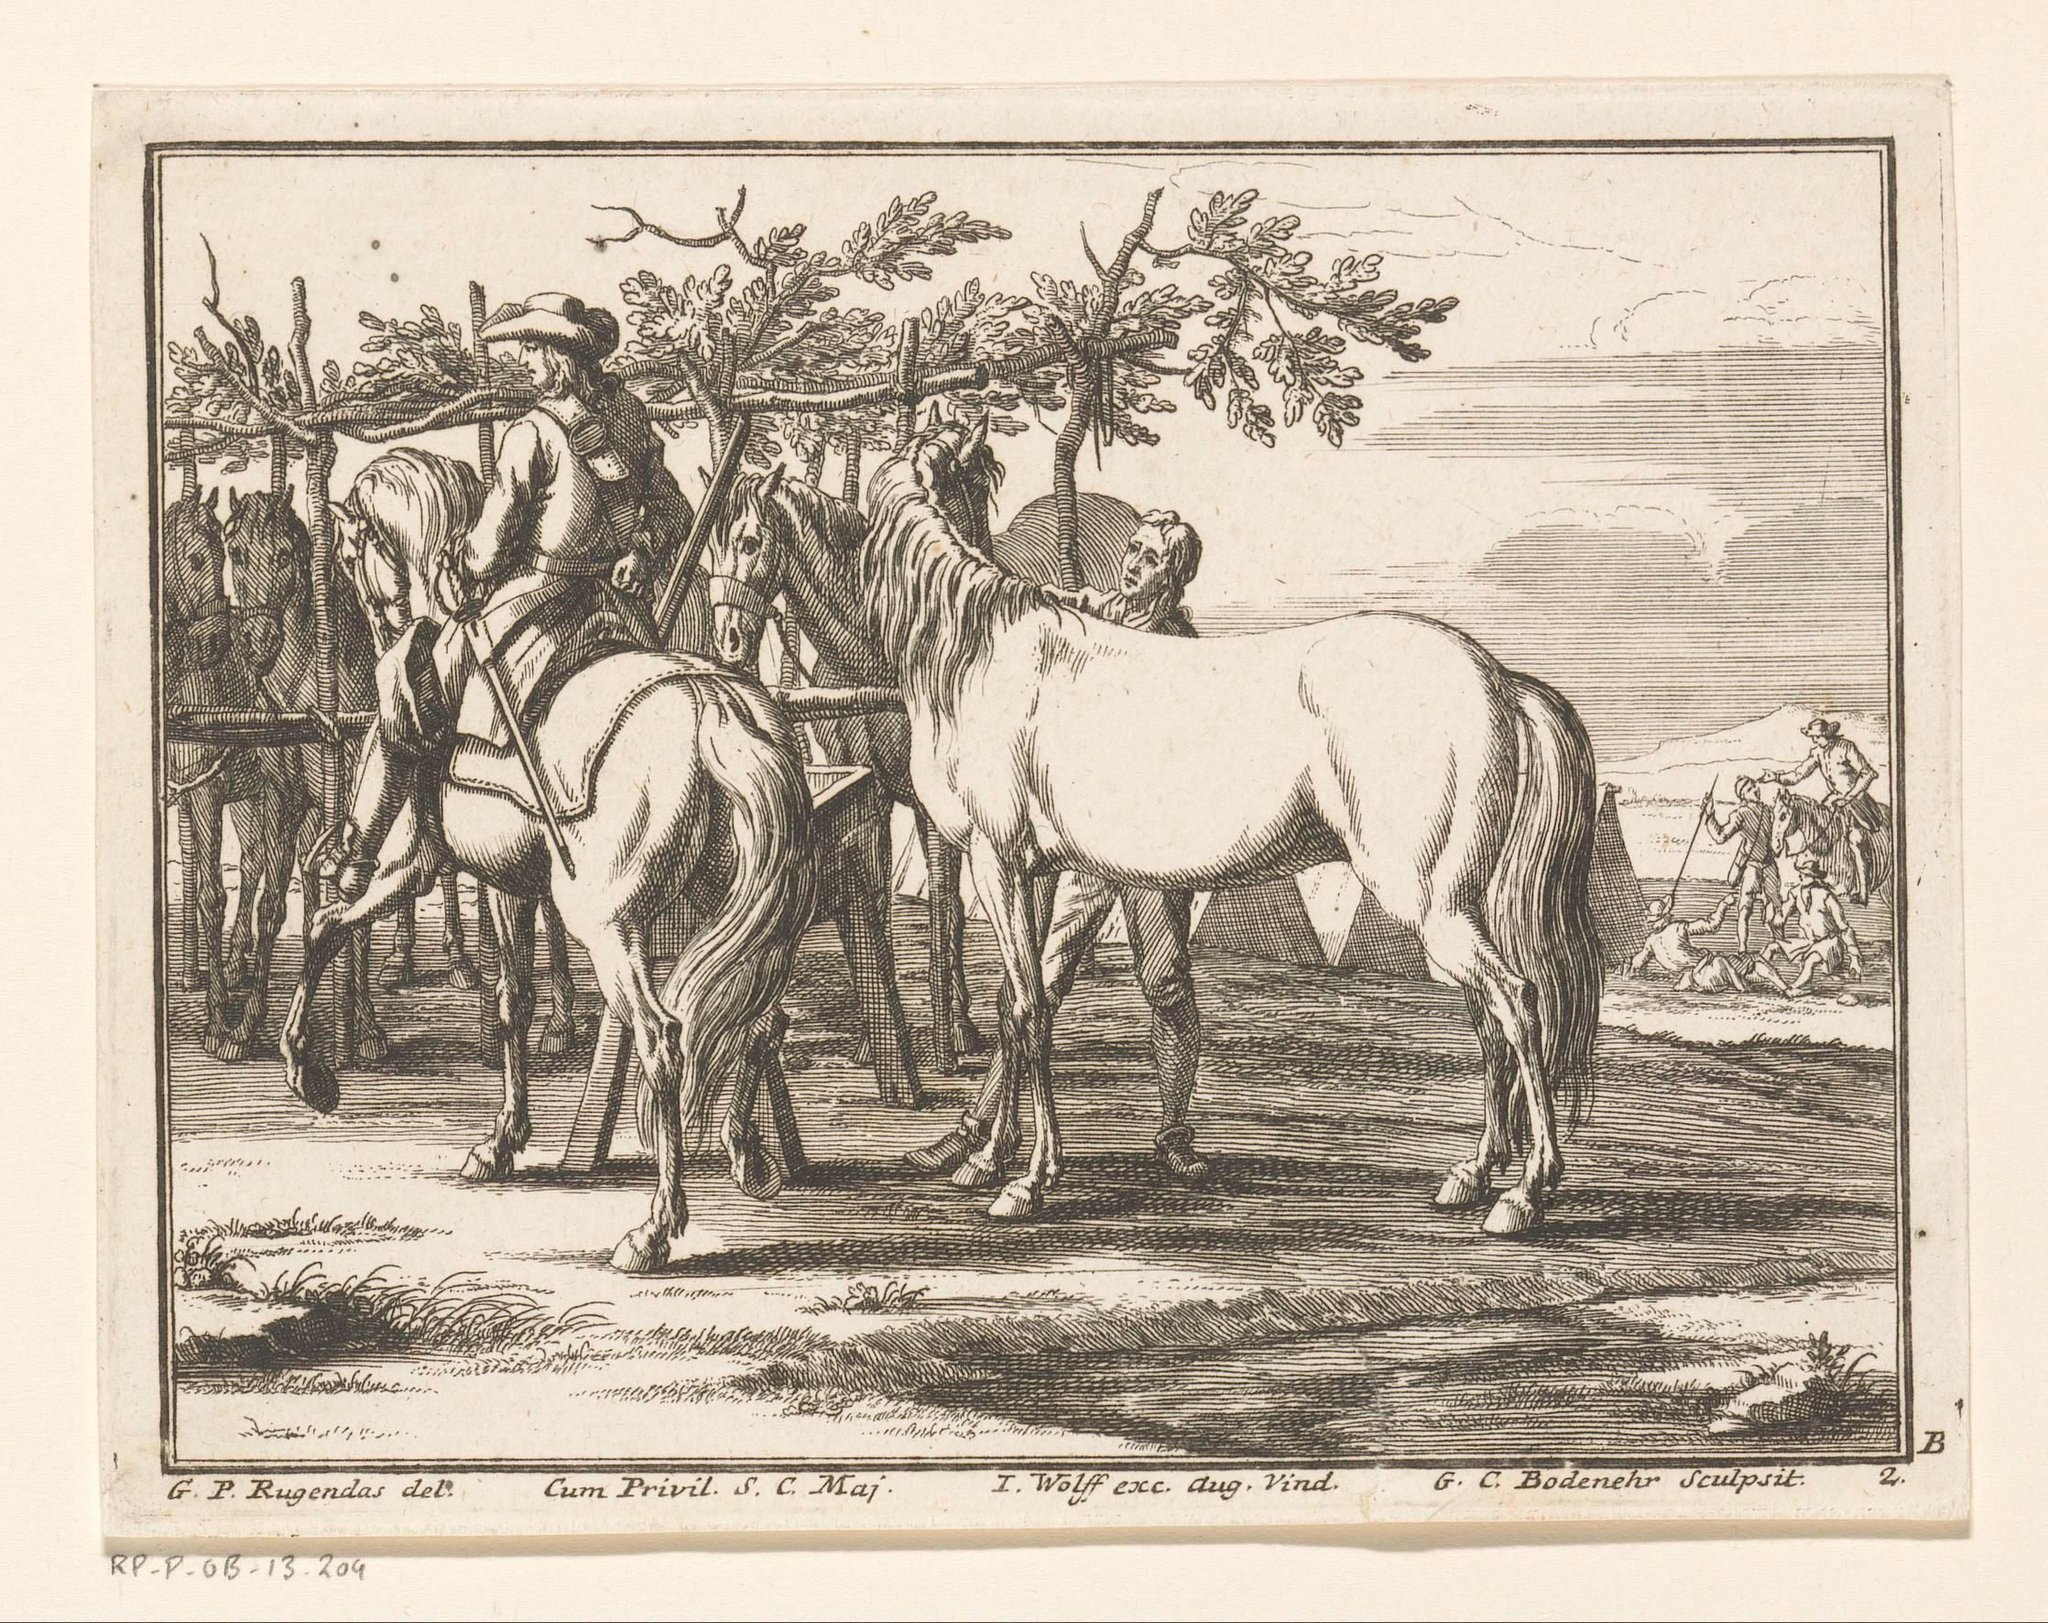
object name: print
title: Ruiters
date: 1686-1710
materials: paper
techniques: etching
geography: augsburg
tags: private soldier (+ cavalry, horsemen), (military) camp with tents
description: Onderdeel van in totaal 37 prenten door Georg Conrad Bodenehr naar Georg Philip Rugendas I. Deze prent maakt onderdeel uit van serie 'B', bestaand uit acht prenten met ruiters.